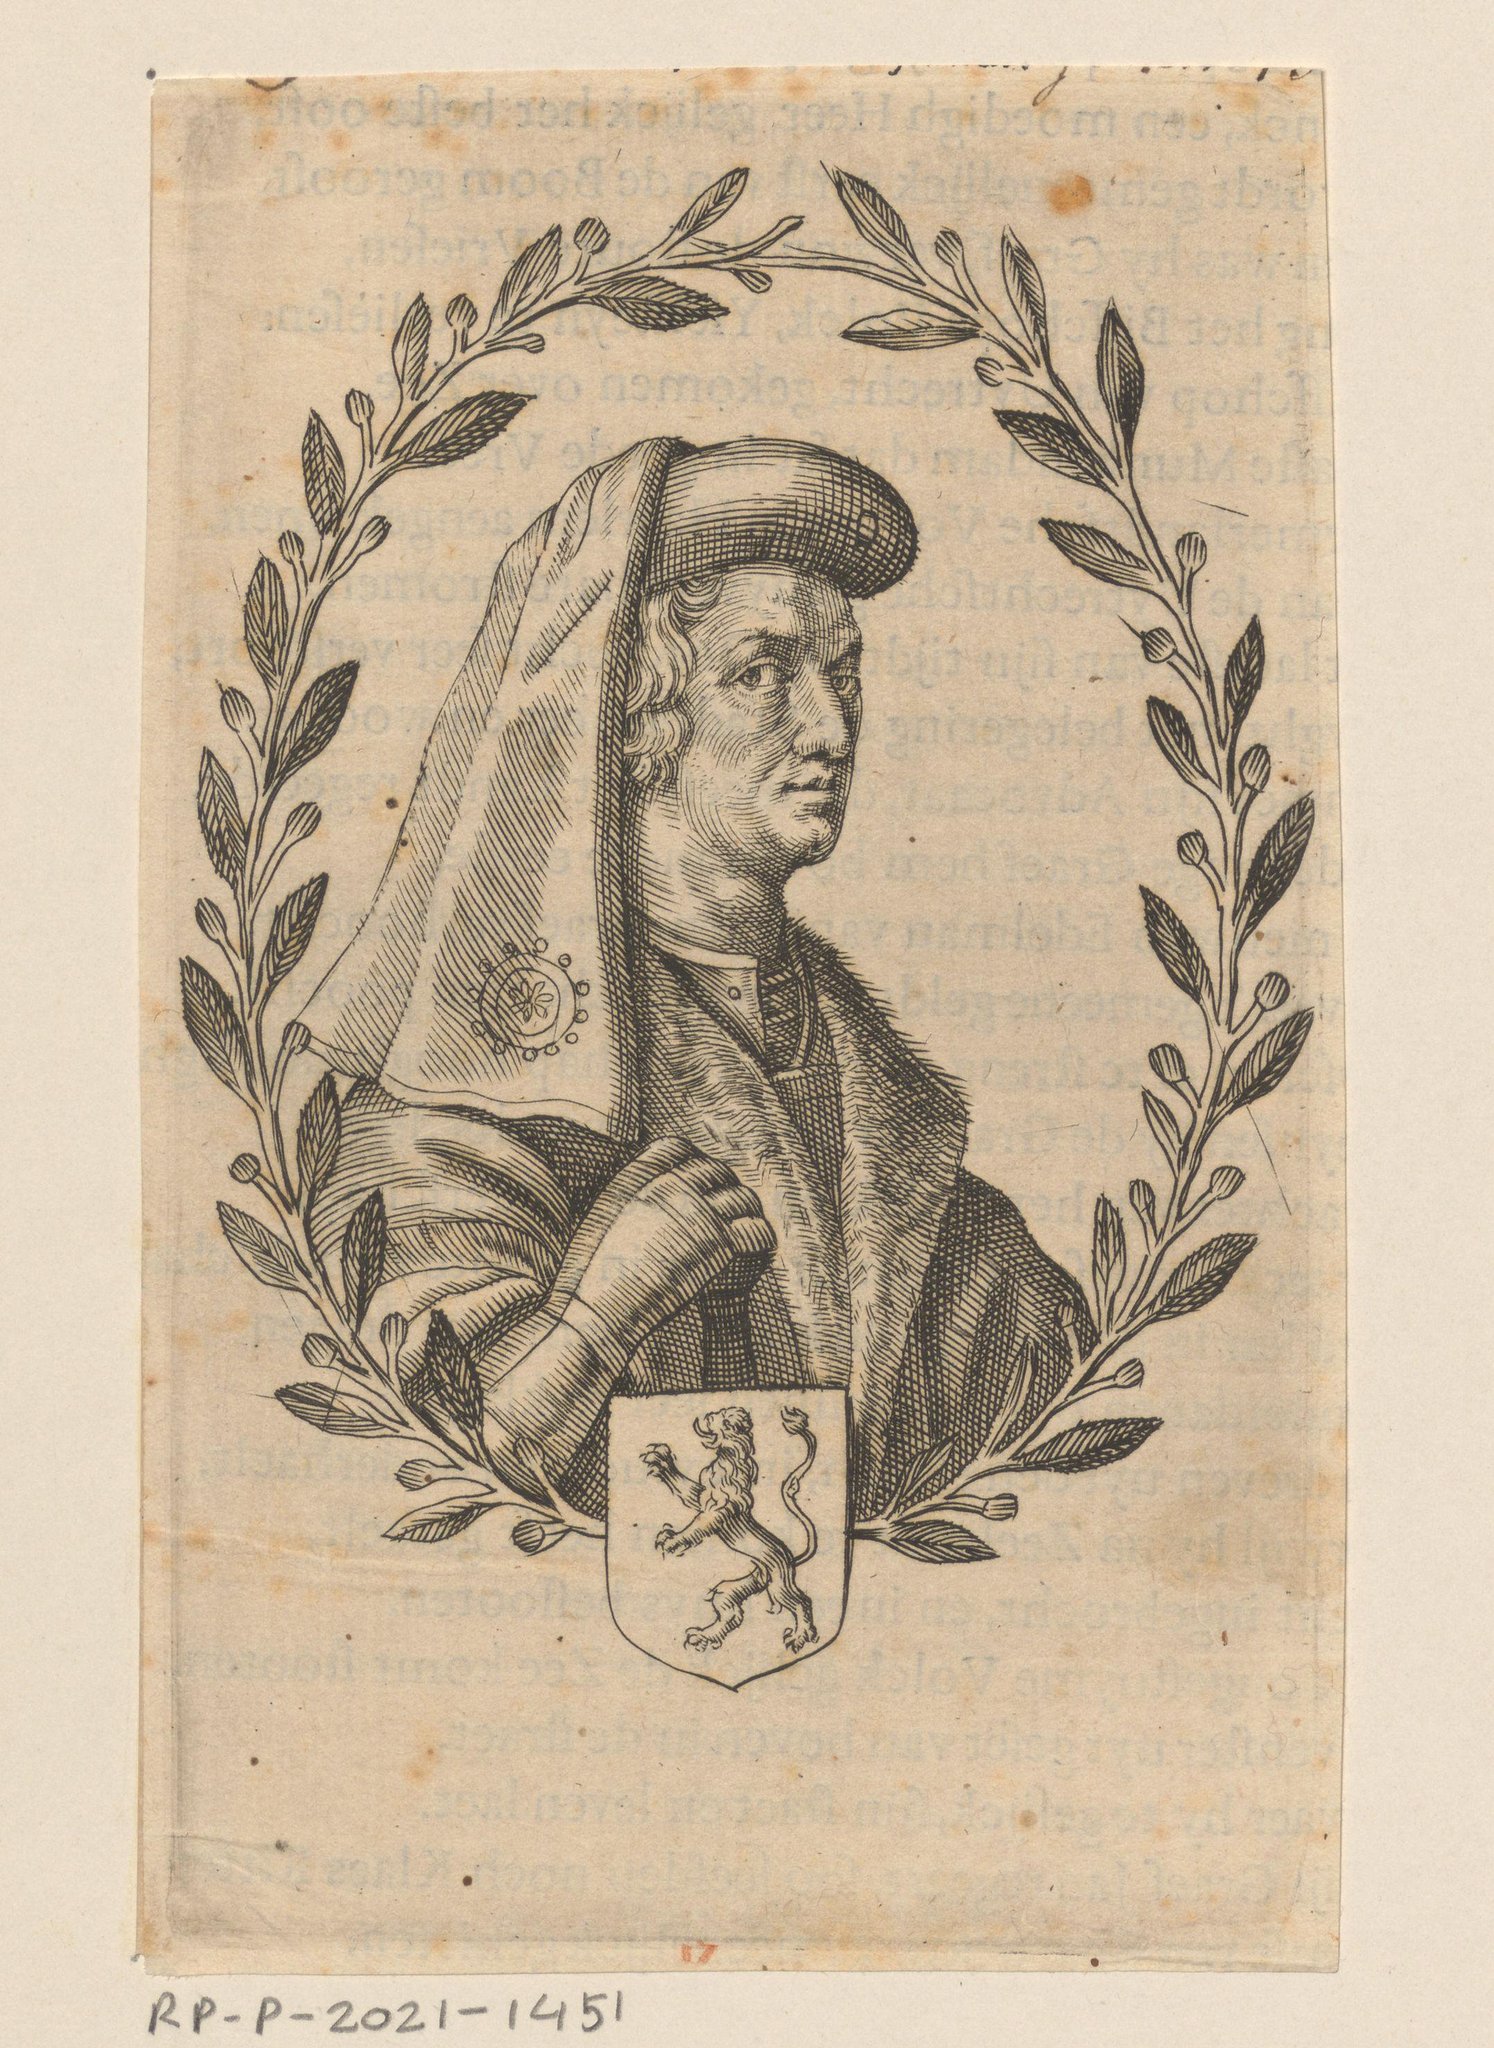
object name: print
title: Portret van Jan I, graaf van Holland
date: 1645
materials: paper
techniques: engraving, letterpress printing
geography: amsterdam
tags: earl, jan i (graaf van holland), historical persons, ruler, sovereign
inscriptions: collector's mark: Lugt 240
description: Prent uit: Wachtendorp, Caspar. Oude Hollandsche geschiedenissen ofte, korte Hollandtsche rym-kronyck. 14 dln. Amsterdam: Johannes Pauli, 1645. Prent ook gebruikt in latere publicatie (1648).